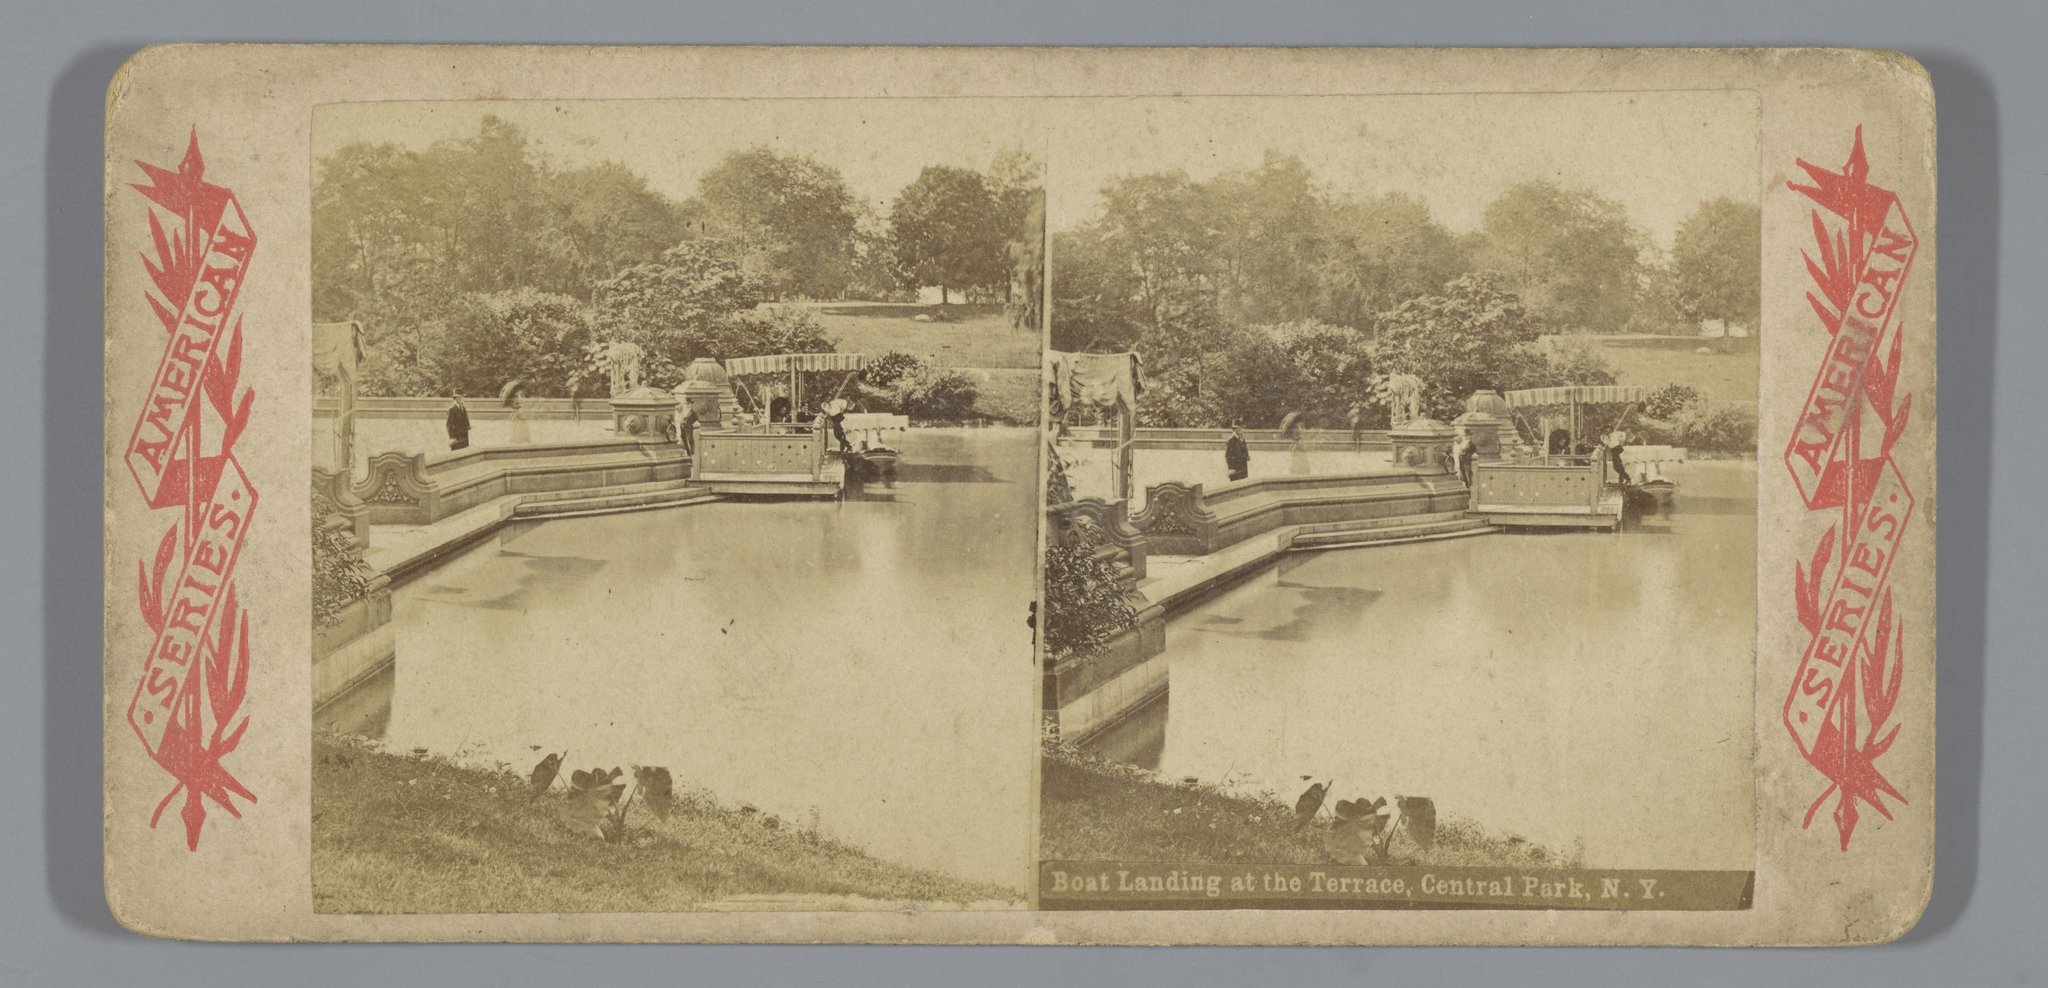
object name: stereograph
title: Boat Landing at the Terrace, Central Park, N.Y.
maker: Anonymous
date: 1868-1890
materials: cardboard, paper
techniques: albumen print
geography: new york city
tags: rowing-boat, canoe, etc., lake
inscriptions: retailer's mark: ‘F. G. A. Manders/ Amsterdam’, number: ‘15’